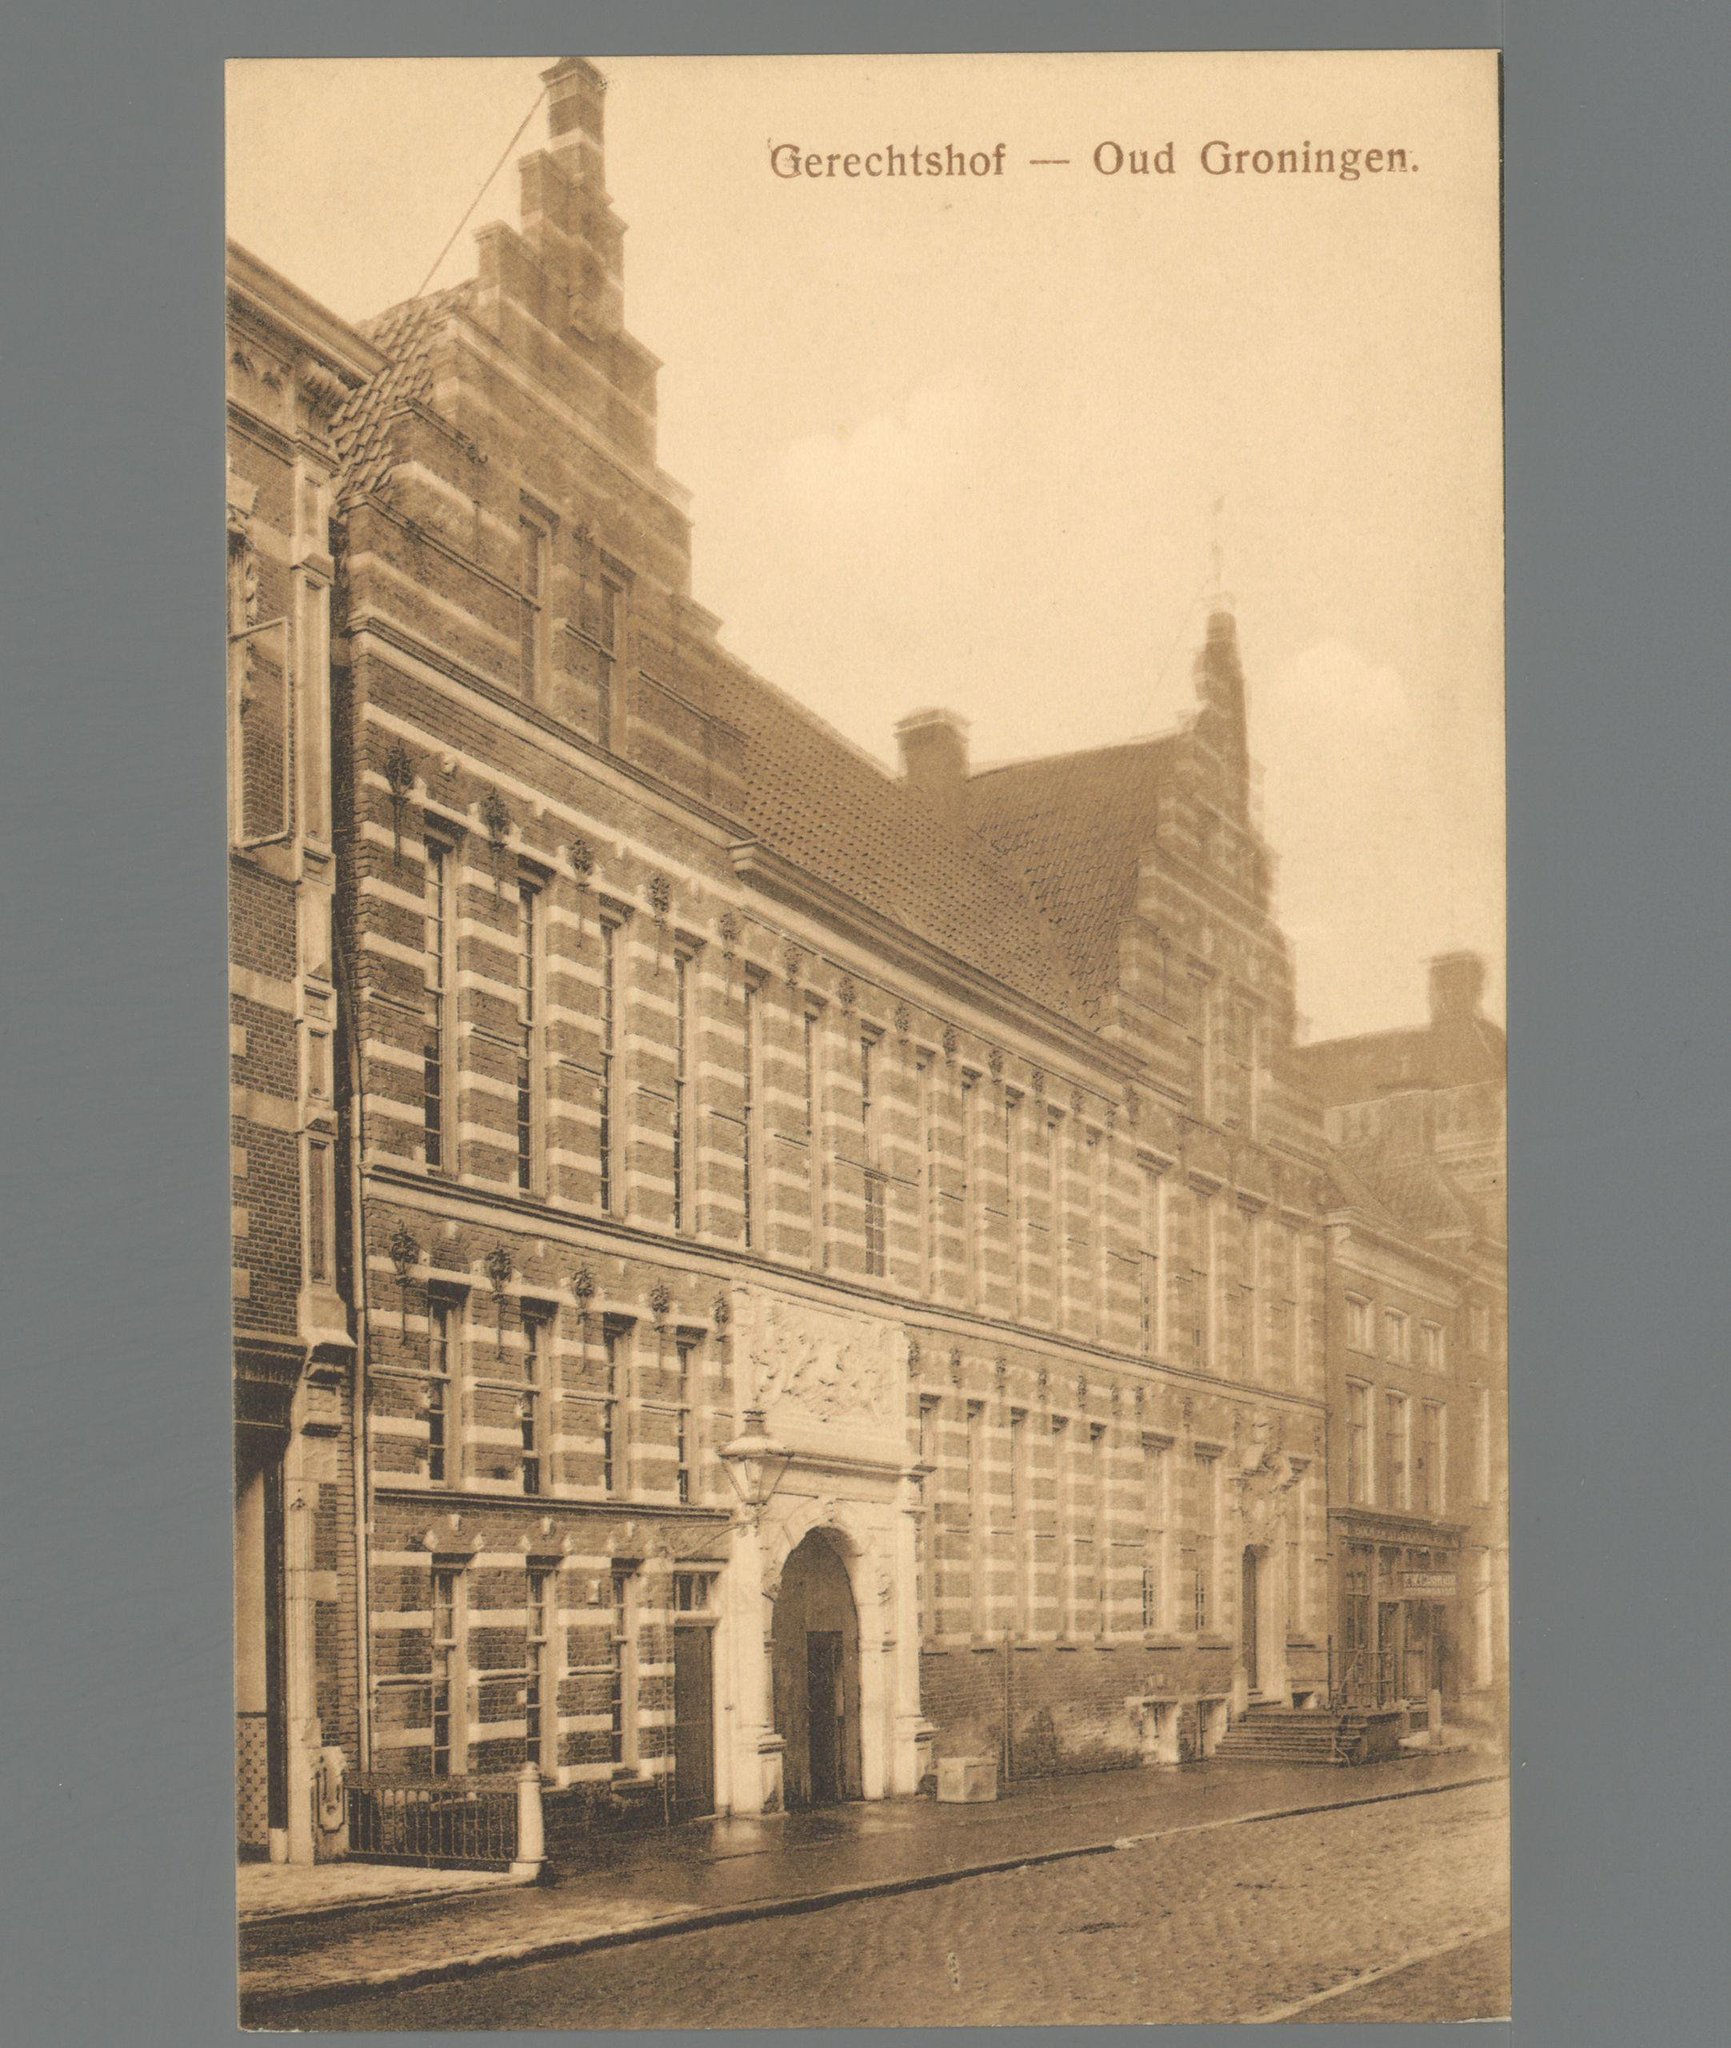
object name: ansichtkaart, prentbriefkaart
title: Gerechtshof - Oud Groningen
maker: Anonymous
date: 1905-1930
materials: cardboard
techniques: photograph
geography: zwolle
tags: court building